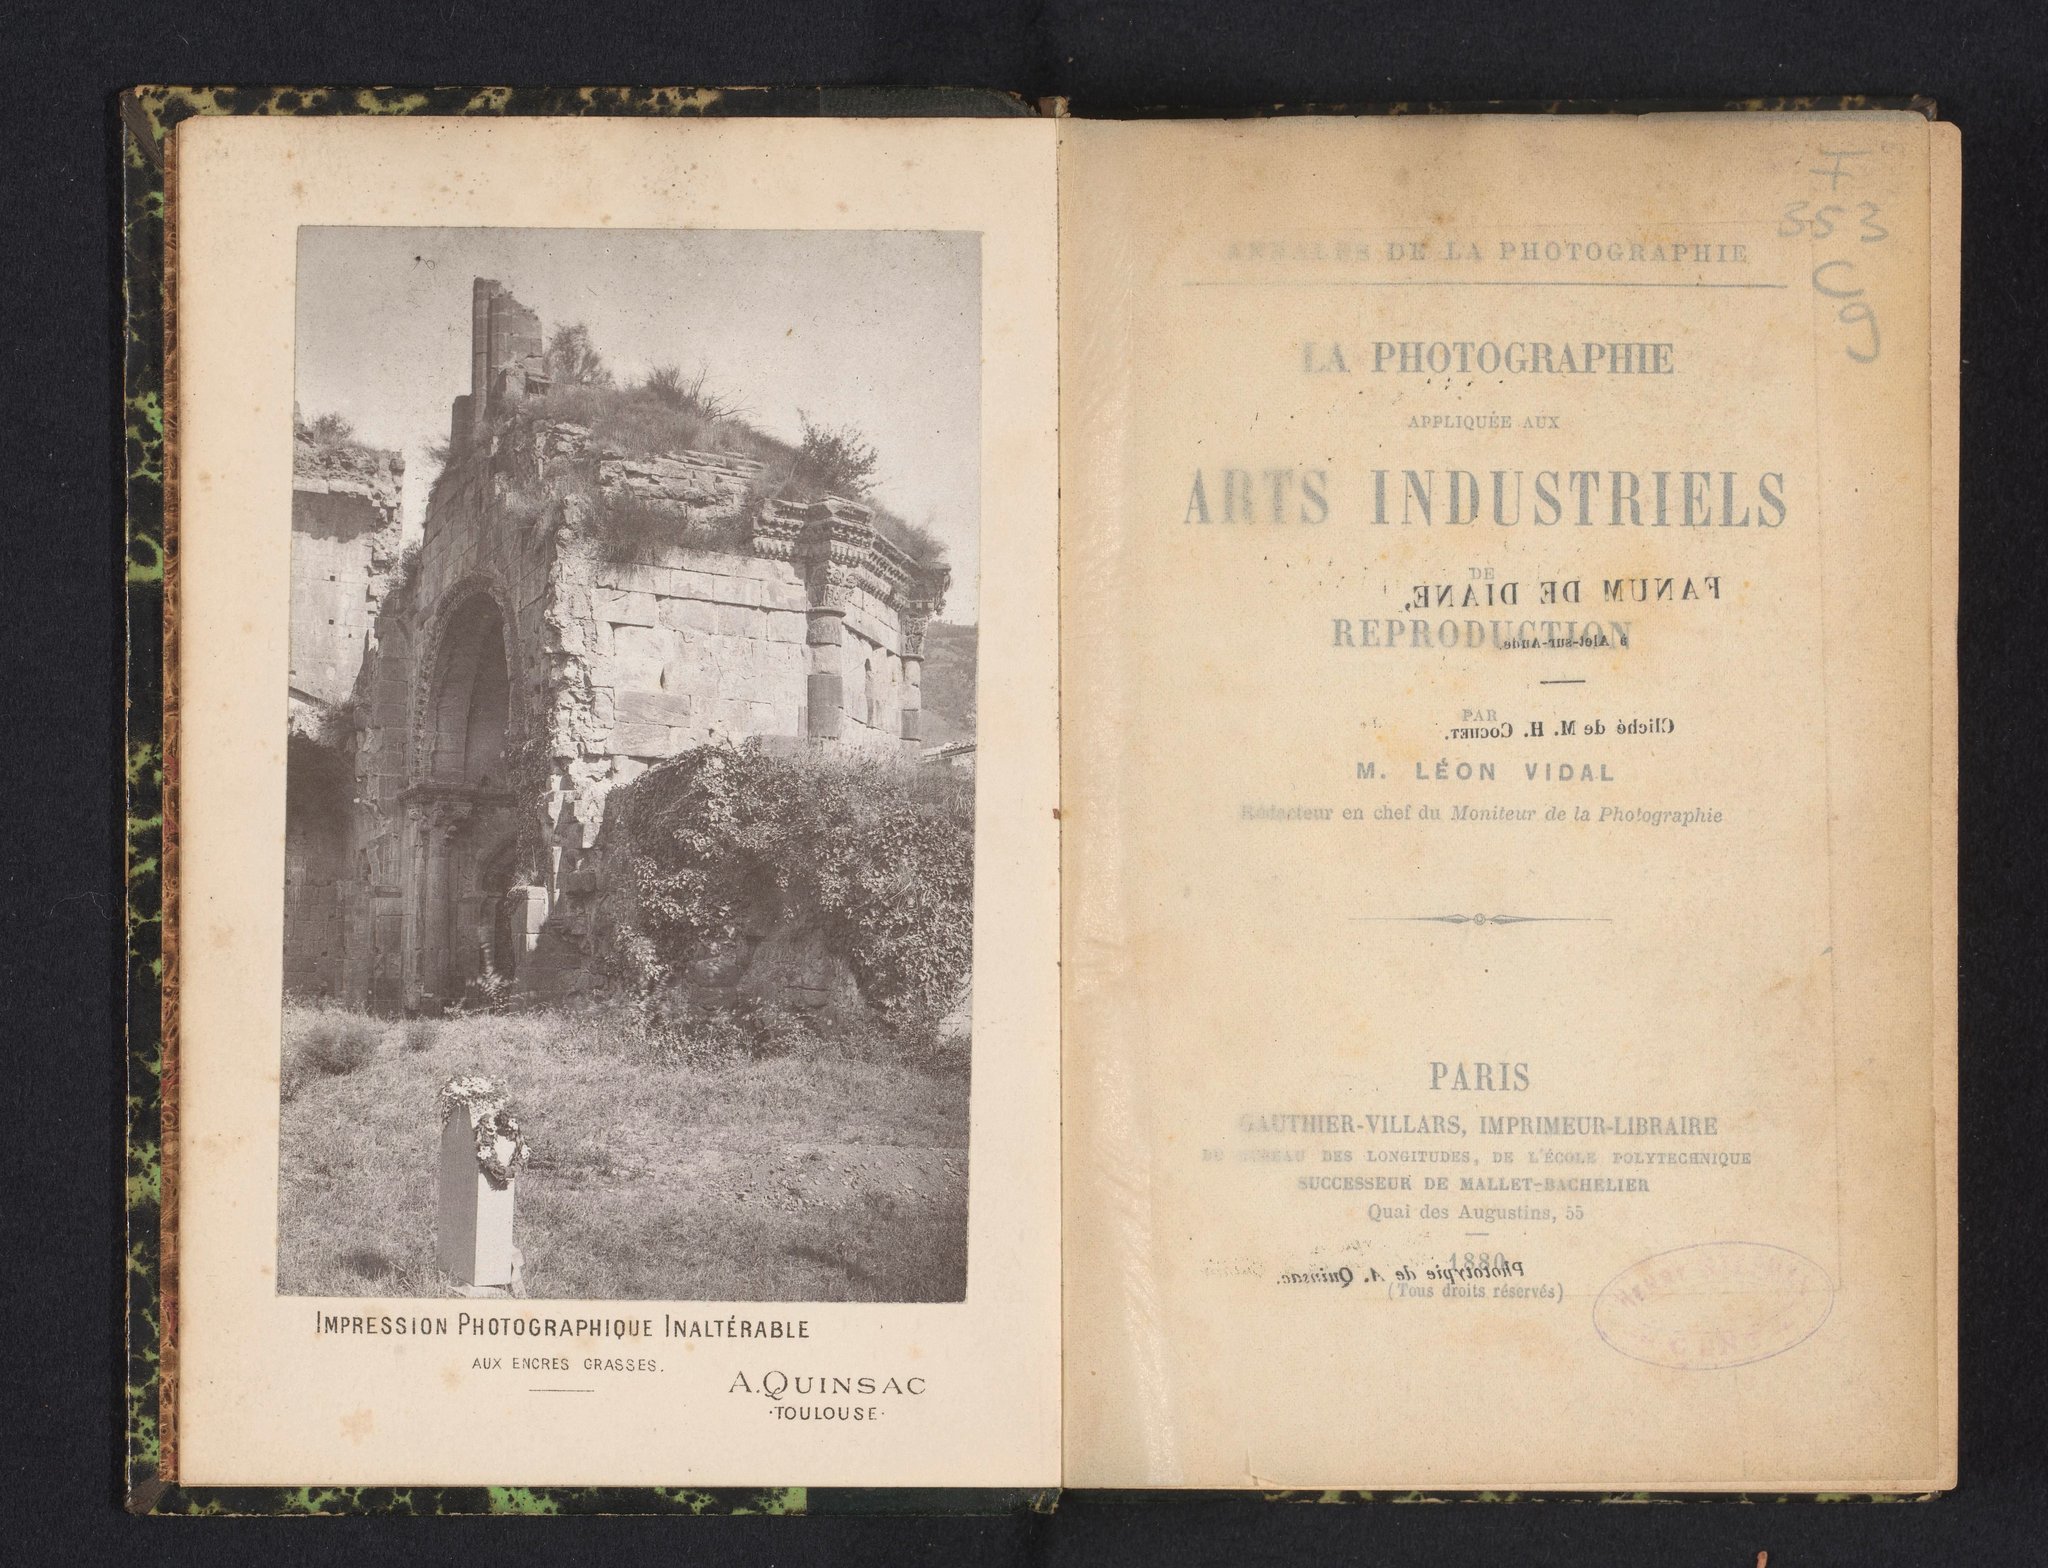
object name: page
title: Gezicht op de ruïne van de abdij van Alet-les-Bains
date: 1870-1880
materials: paper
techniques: photograph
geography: alet-les-bains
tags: ruin of church, monastery, etc.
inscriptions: inscription: ‘Impression Photographique Inaltérable aux encres grasses.’